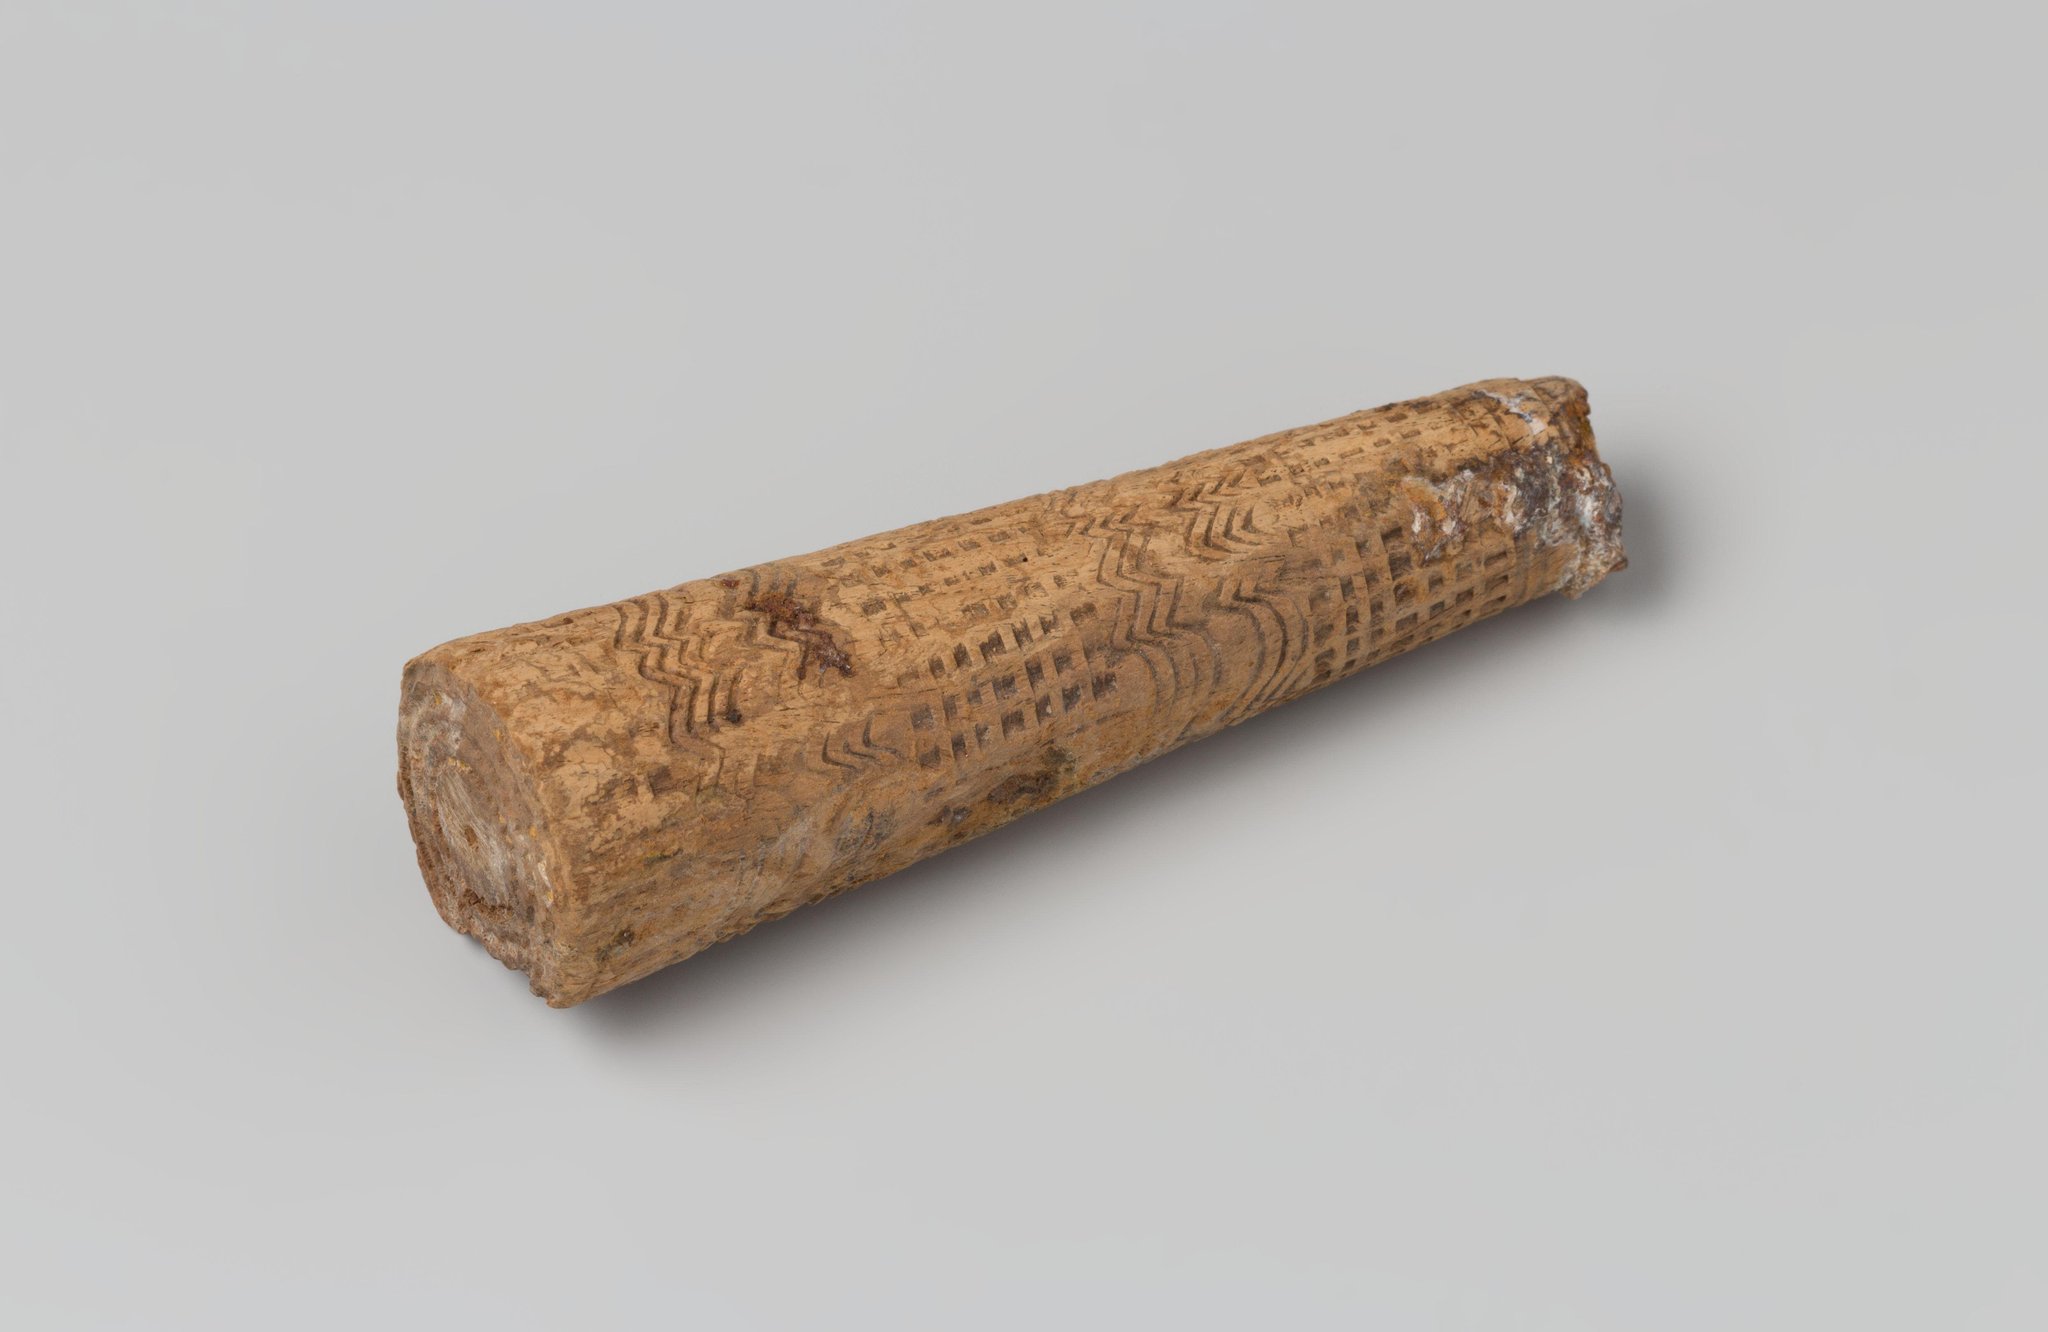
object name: knife handle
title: Messenheft uit het wrak van de Oost-Indiëvaarder Hollandia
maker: Anonymous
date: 1700-1743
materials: wood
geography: netherlands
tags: verenigde oostindische compagnie, hollandia (schip), annet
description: Knife, handle, cylindrical: tapering; id. NG 1979-403H.